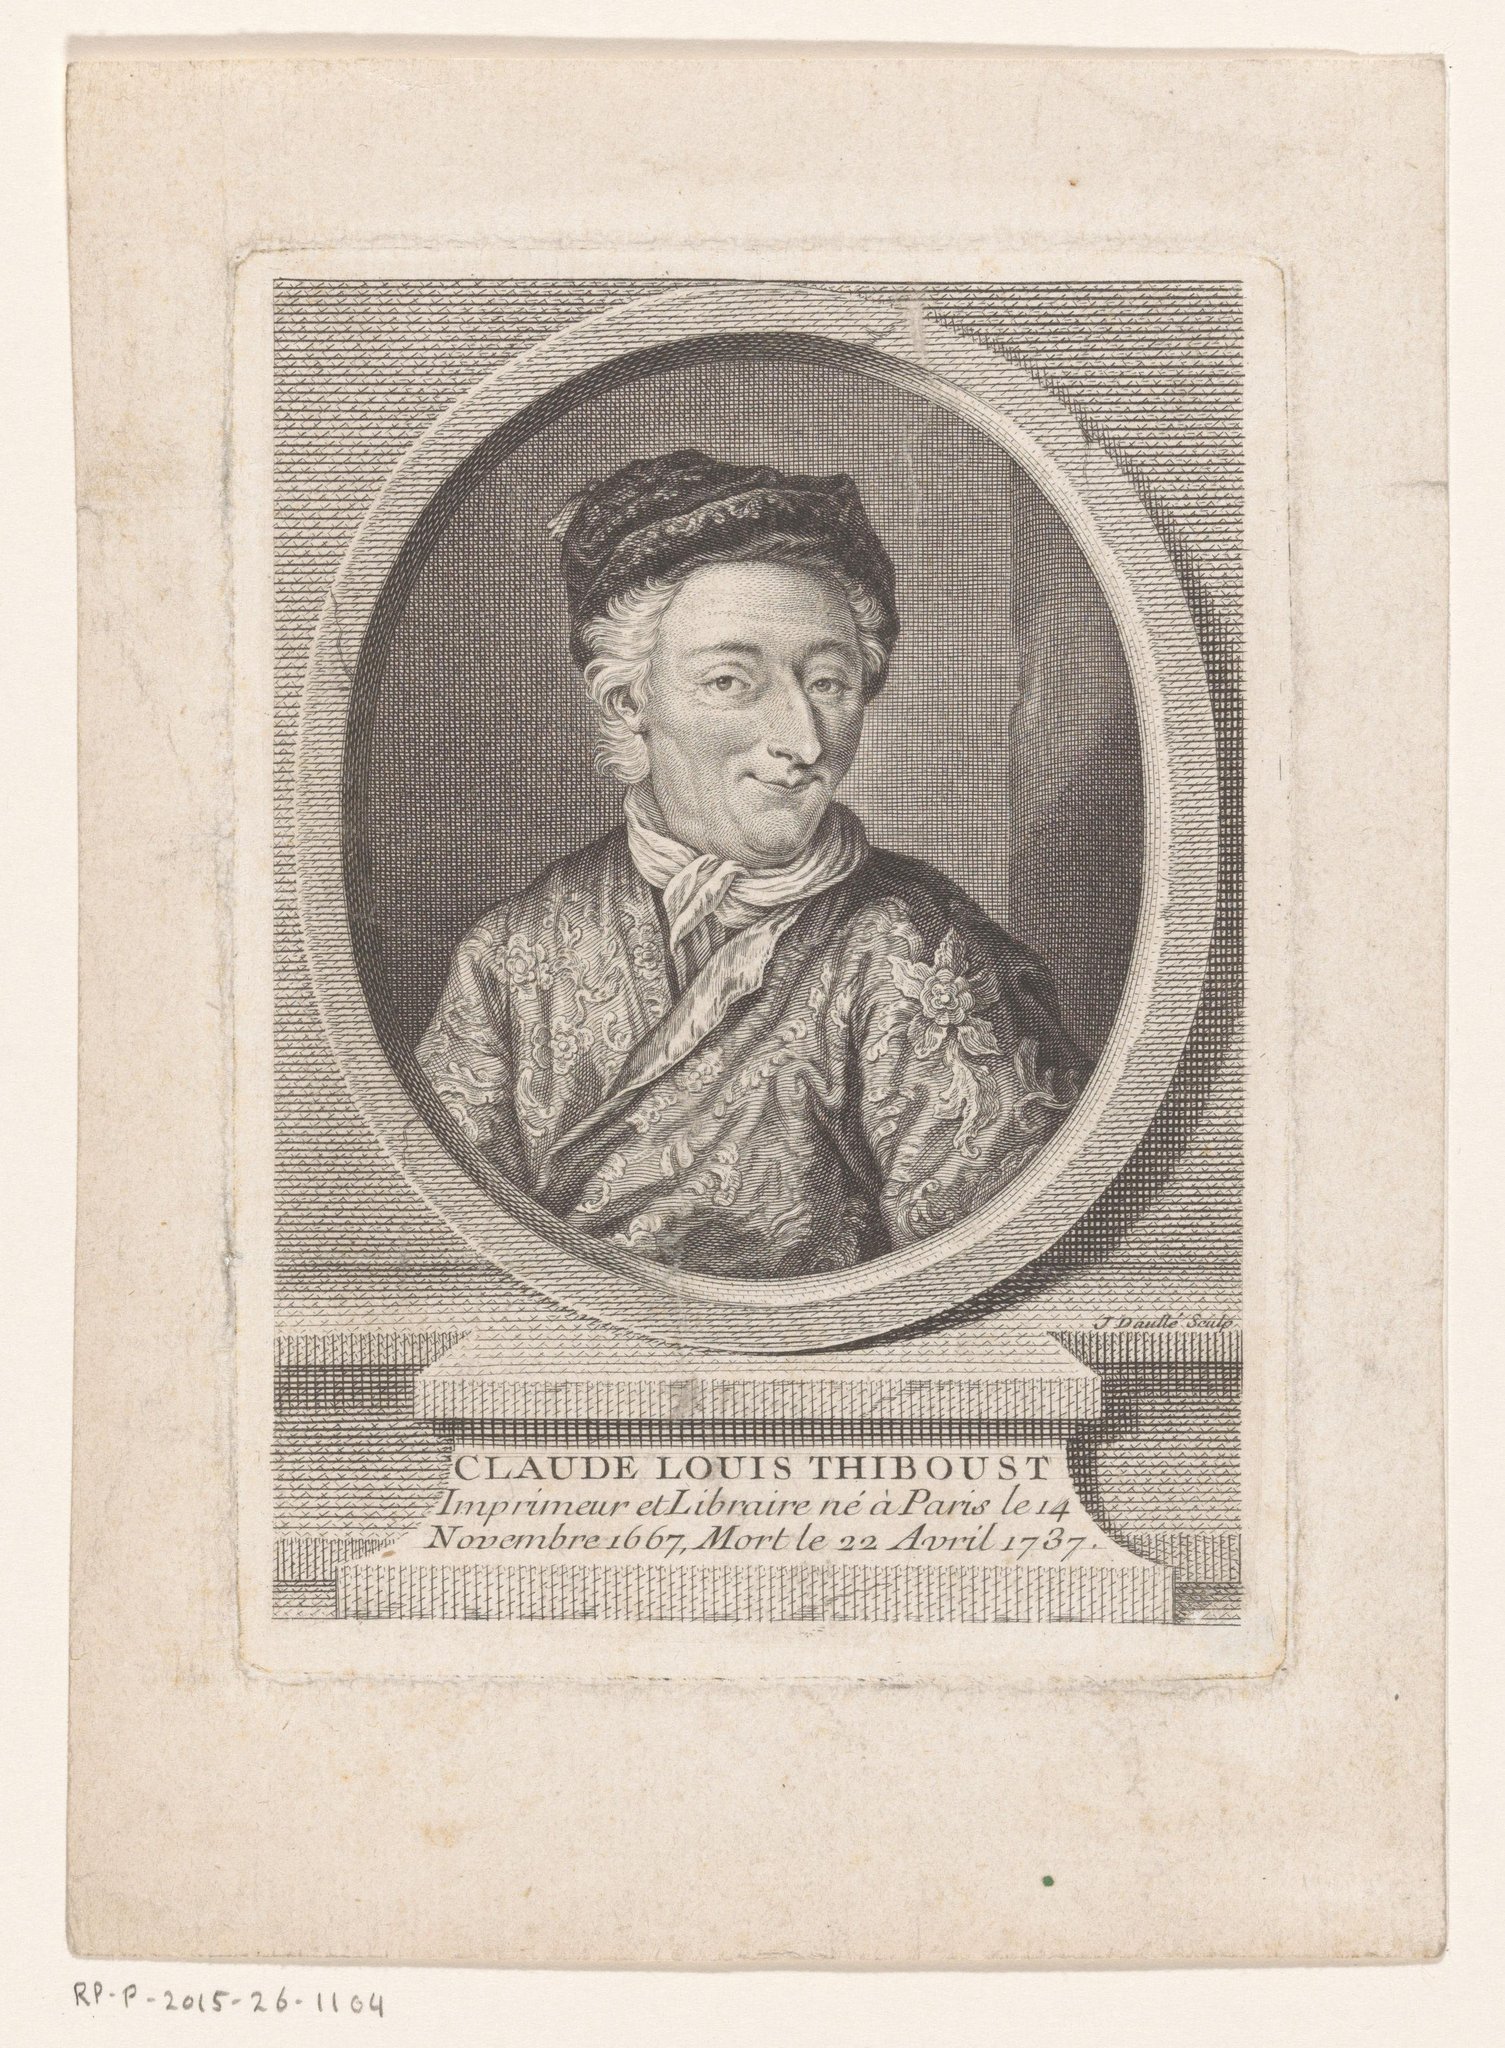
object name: print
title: Portret van Claude Louis Thiboust, boekhandelaar en drukker te Parijs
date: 1737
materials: paper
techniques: engraving, etching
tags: paris, publisher, claude louis thiboust, publishing, publisher, book-shop, bookseller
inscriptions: collector's mark: Lugt 4780, collector's mark: Lugt 2228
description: Volgens de monografie van Auguste Guillaume Crayen is deze prent vervaardigd door Georg Friedrich Schmidt.